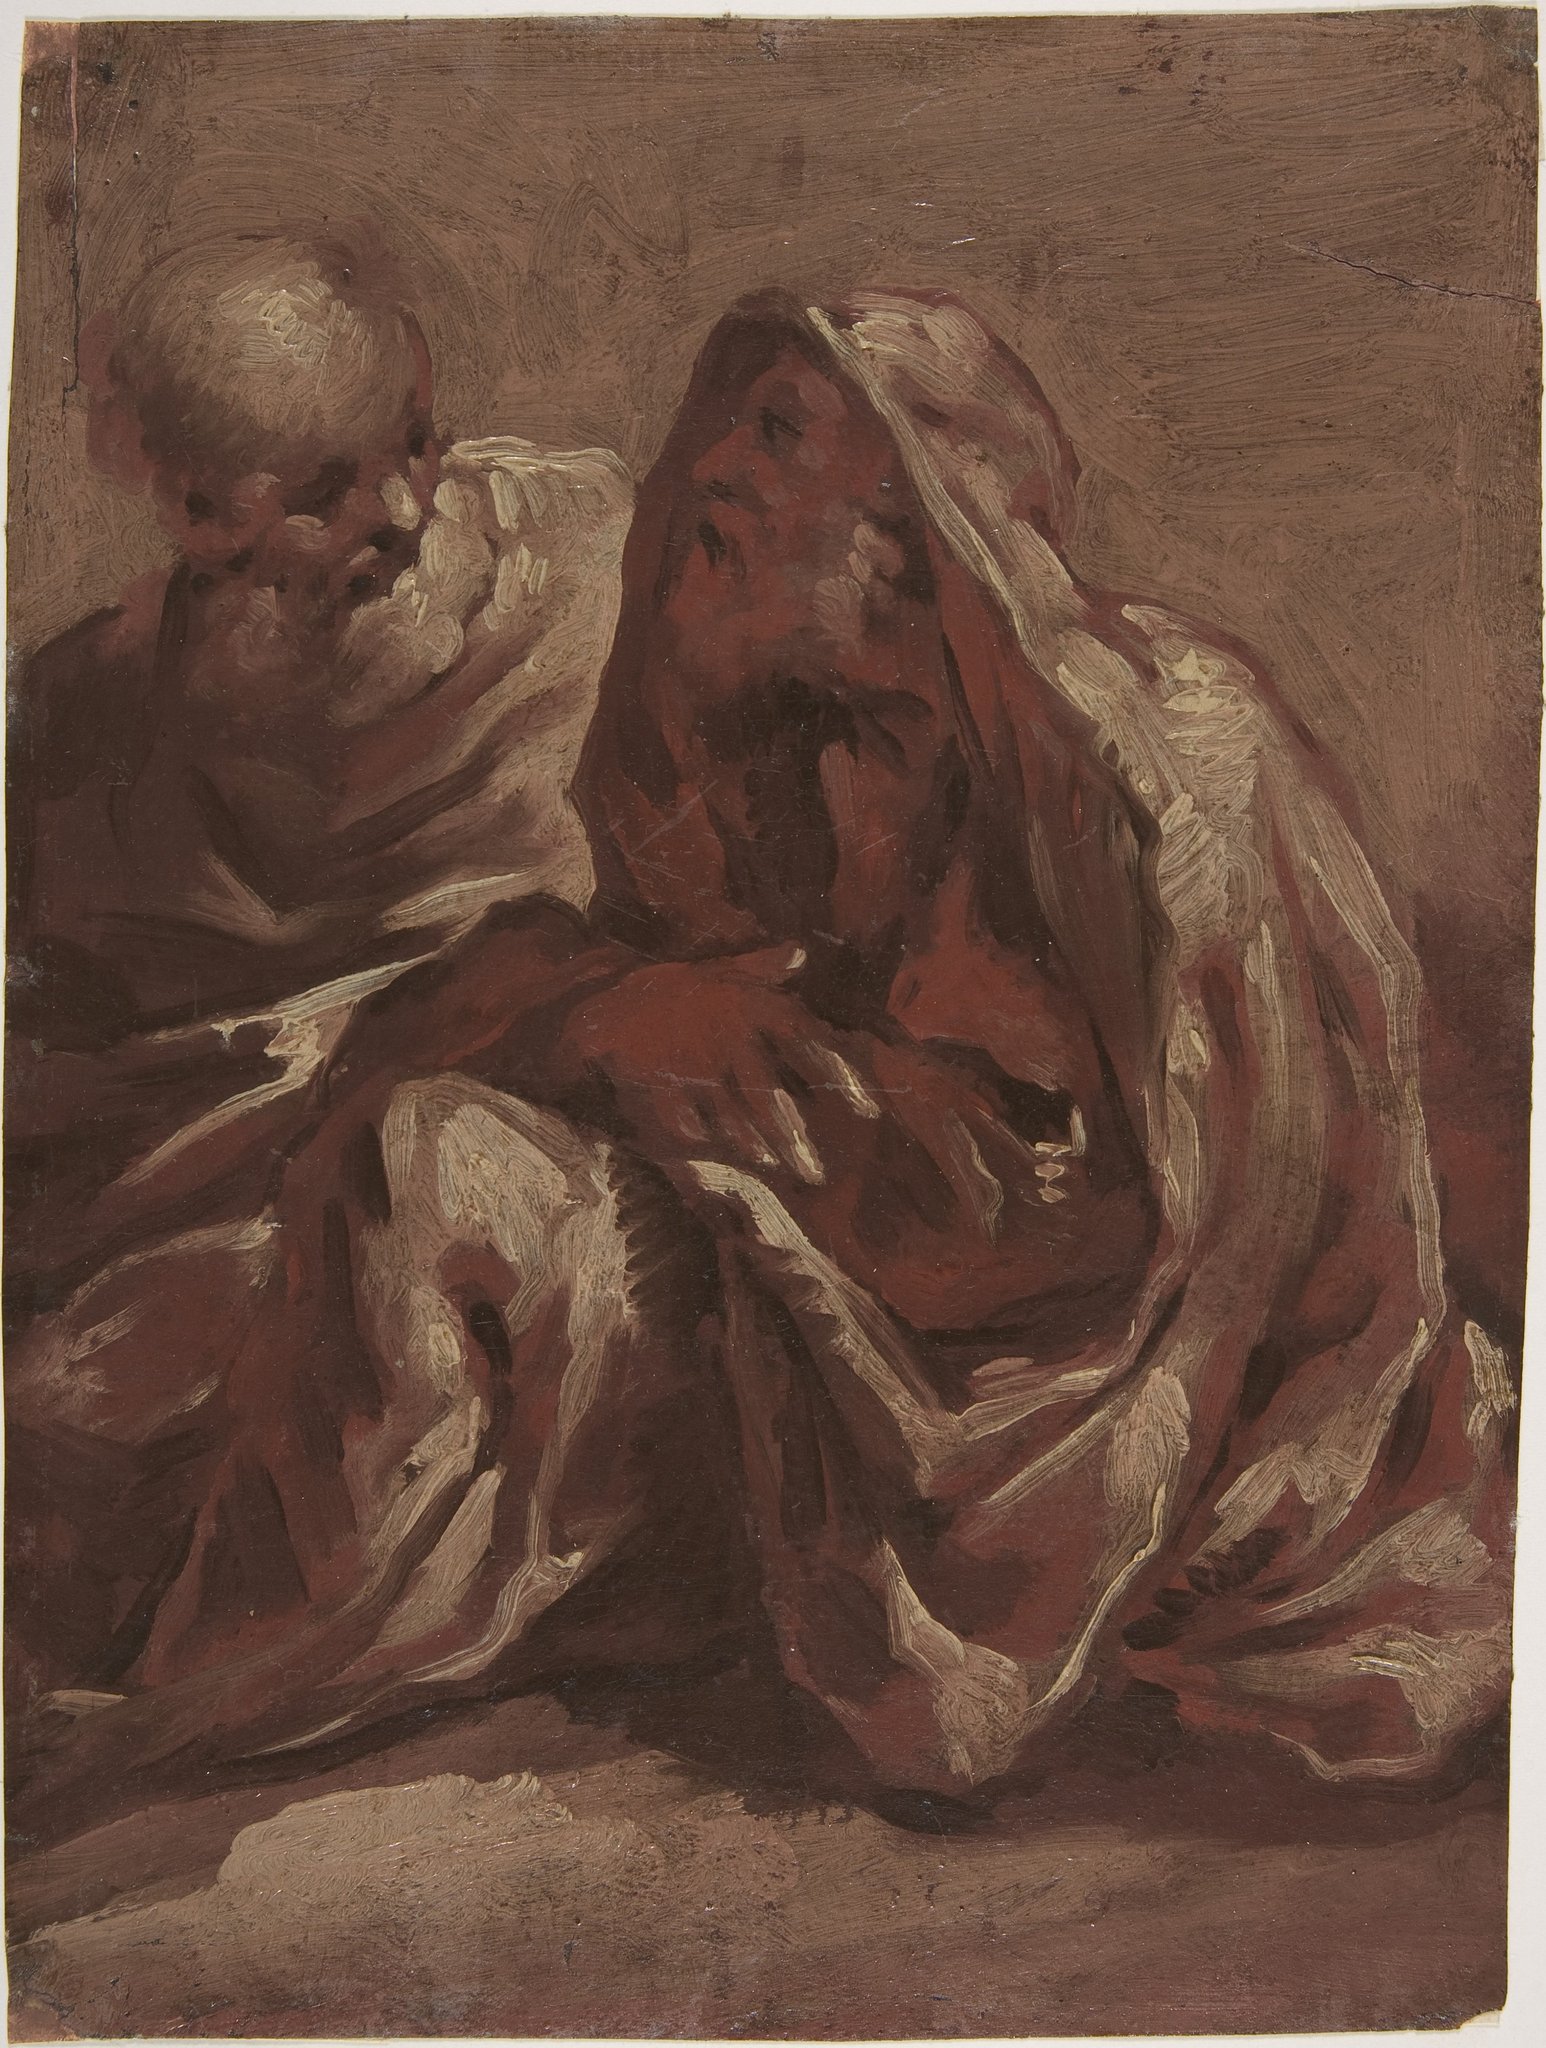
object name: drawing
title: Two Seated Bearded Male Figures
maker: sigismondo caula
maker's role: artist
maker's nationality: italian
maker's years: 1637-1724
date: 1637-1713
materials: paint, varnish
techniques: brush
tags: men